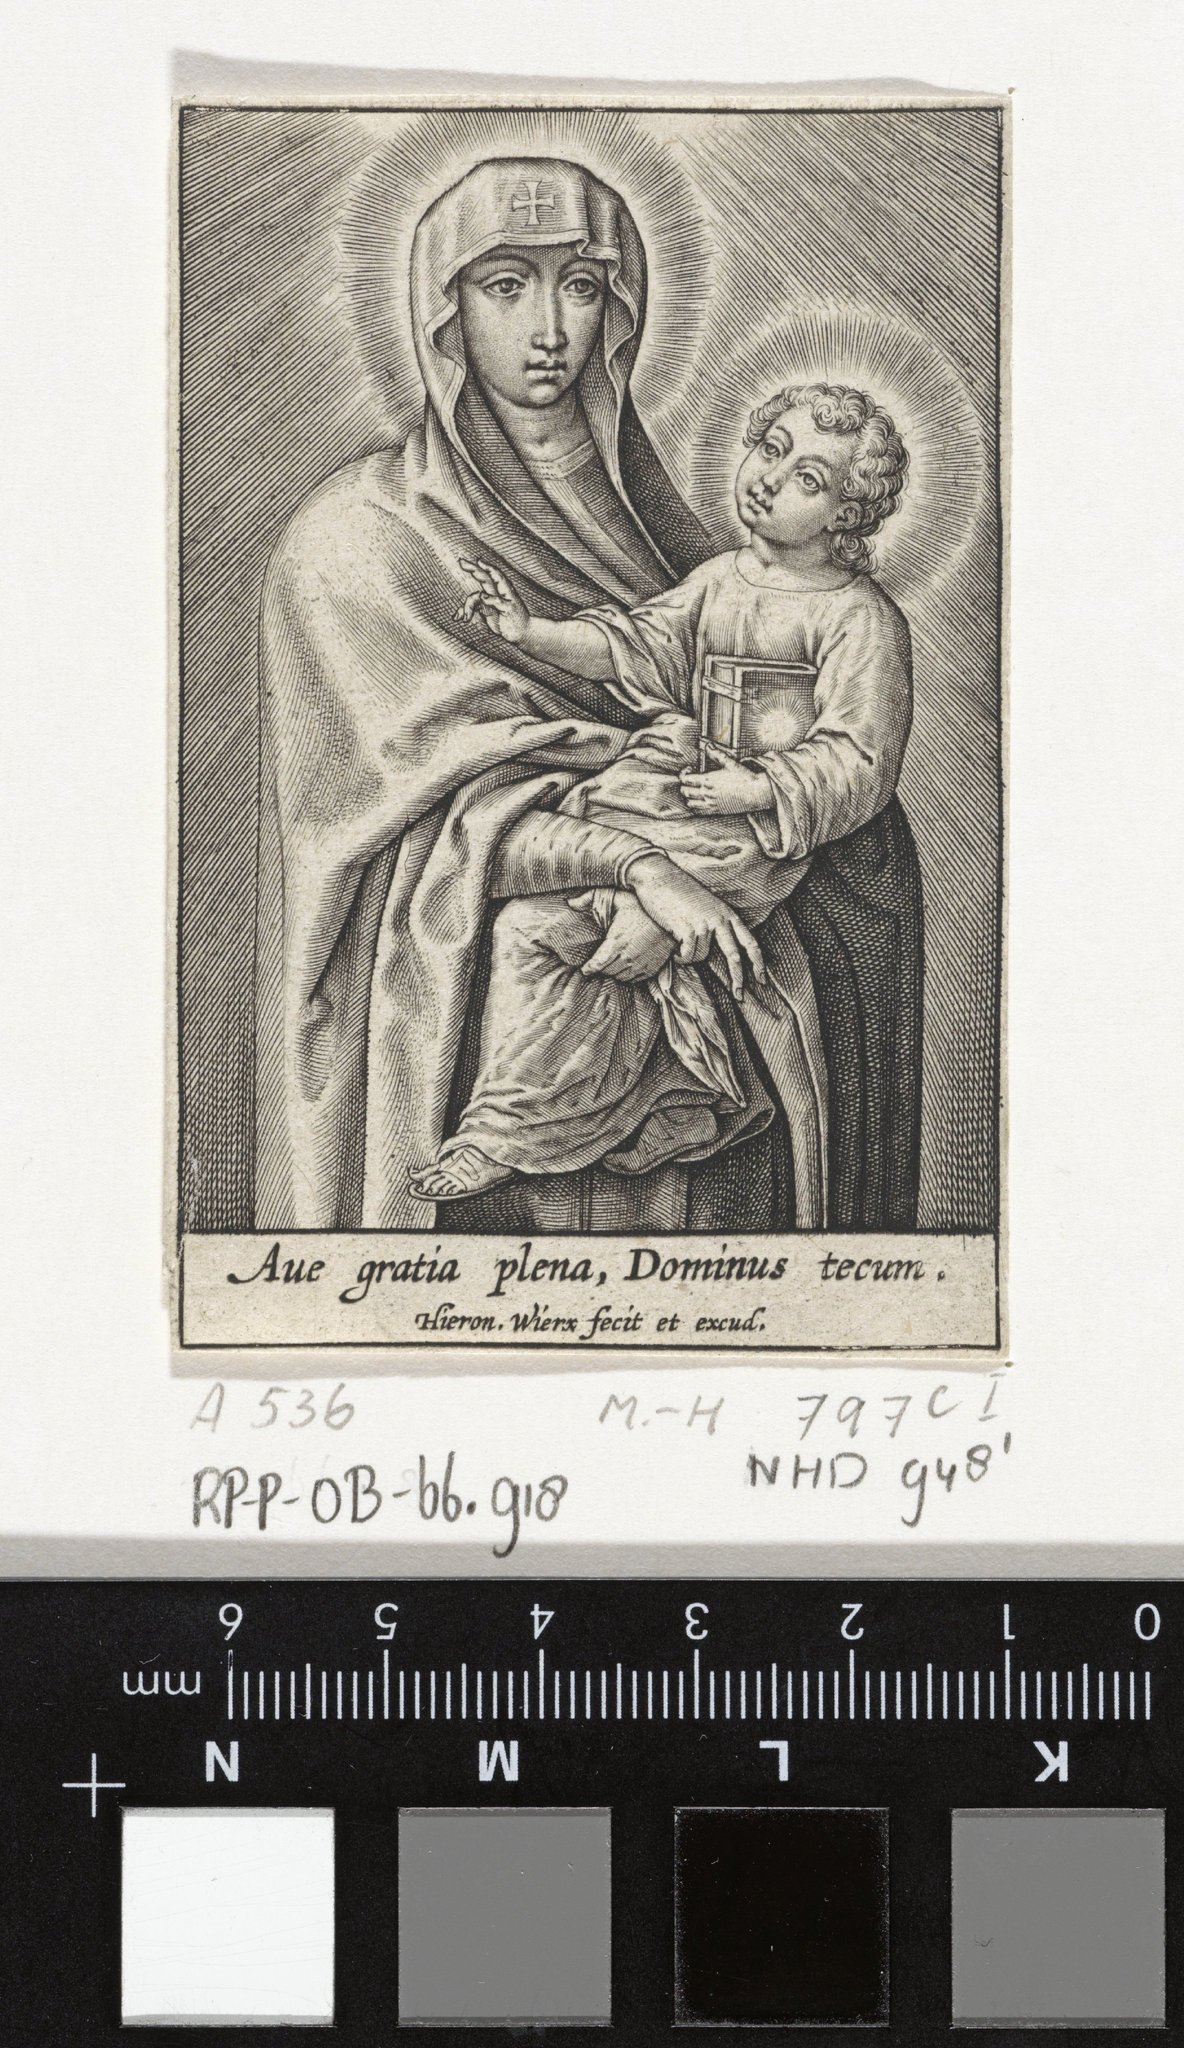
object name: print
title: Maria met het Christuskind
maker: hieronymus wierix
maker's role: draughtsman, print maker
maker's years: 1553-1619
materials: paper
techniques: engraving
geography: antwerp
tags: mary standing (or half-length), the christ-child on her arm (christ-child to mary's left)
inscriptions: number: ‘29.’, collector's mark: Lugt 240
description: De gesluierde Maria draagt het Christuskind in haar armen. Het Kind houdt een boek onder de arm en maakt een zegenend gebaar.